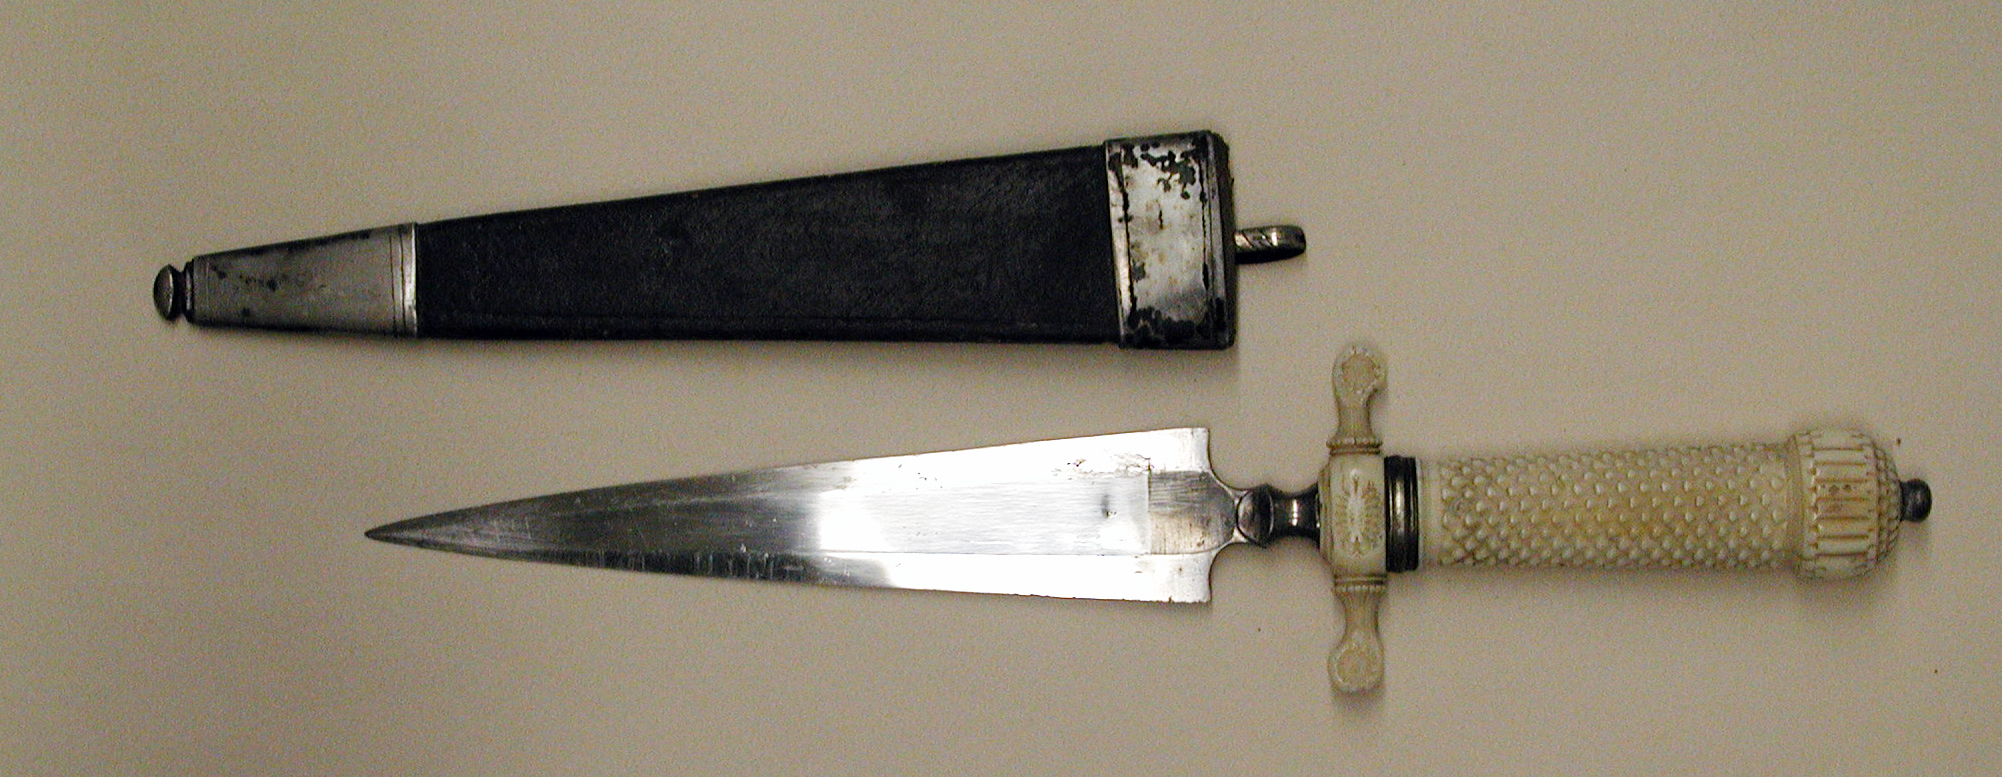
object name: dagger with sheath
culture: german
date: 1767-1800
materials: gold, ivory, leather, silver, steel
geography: germany